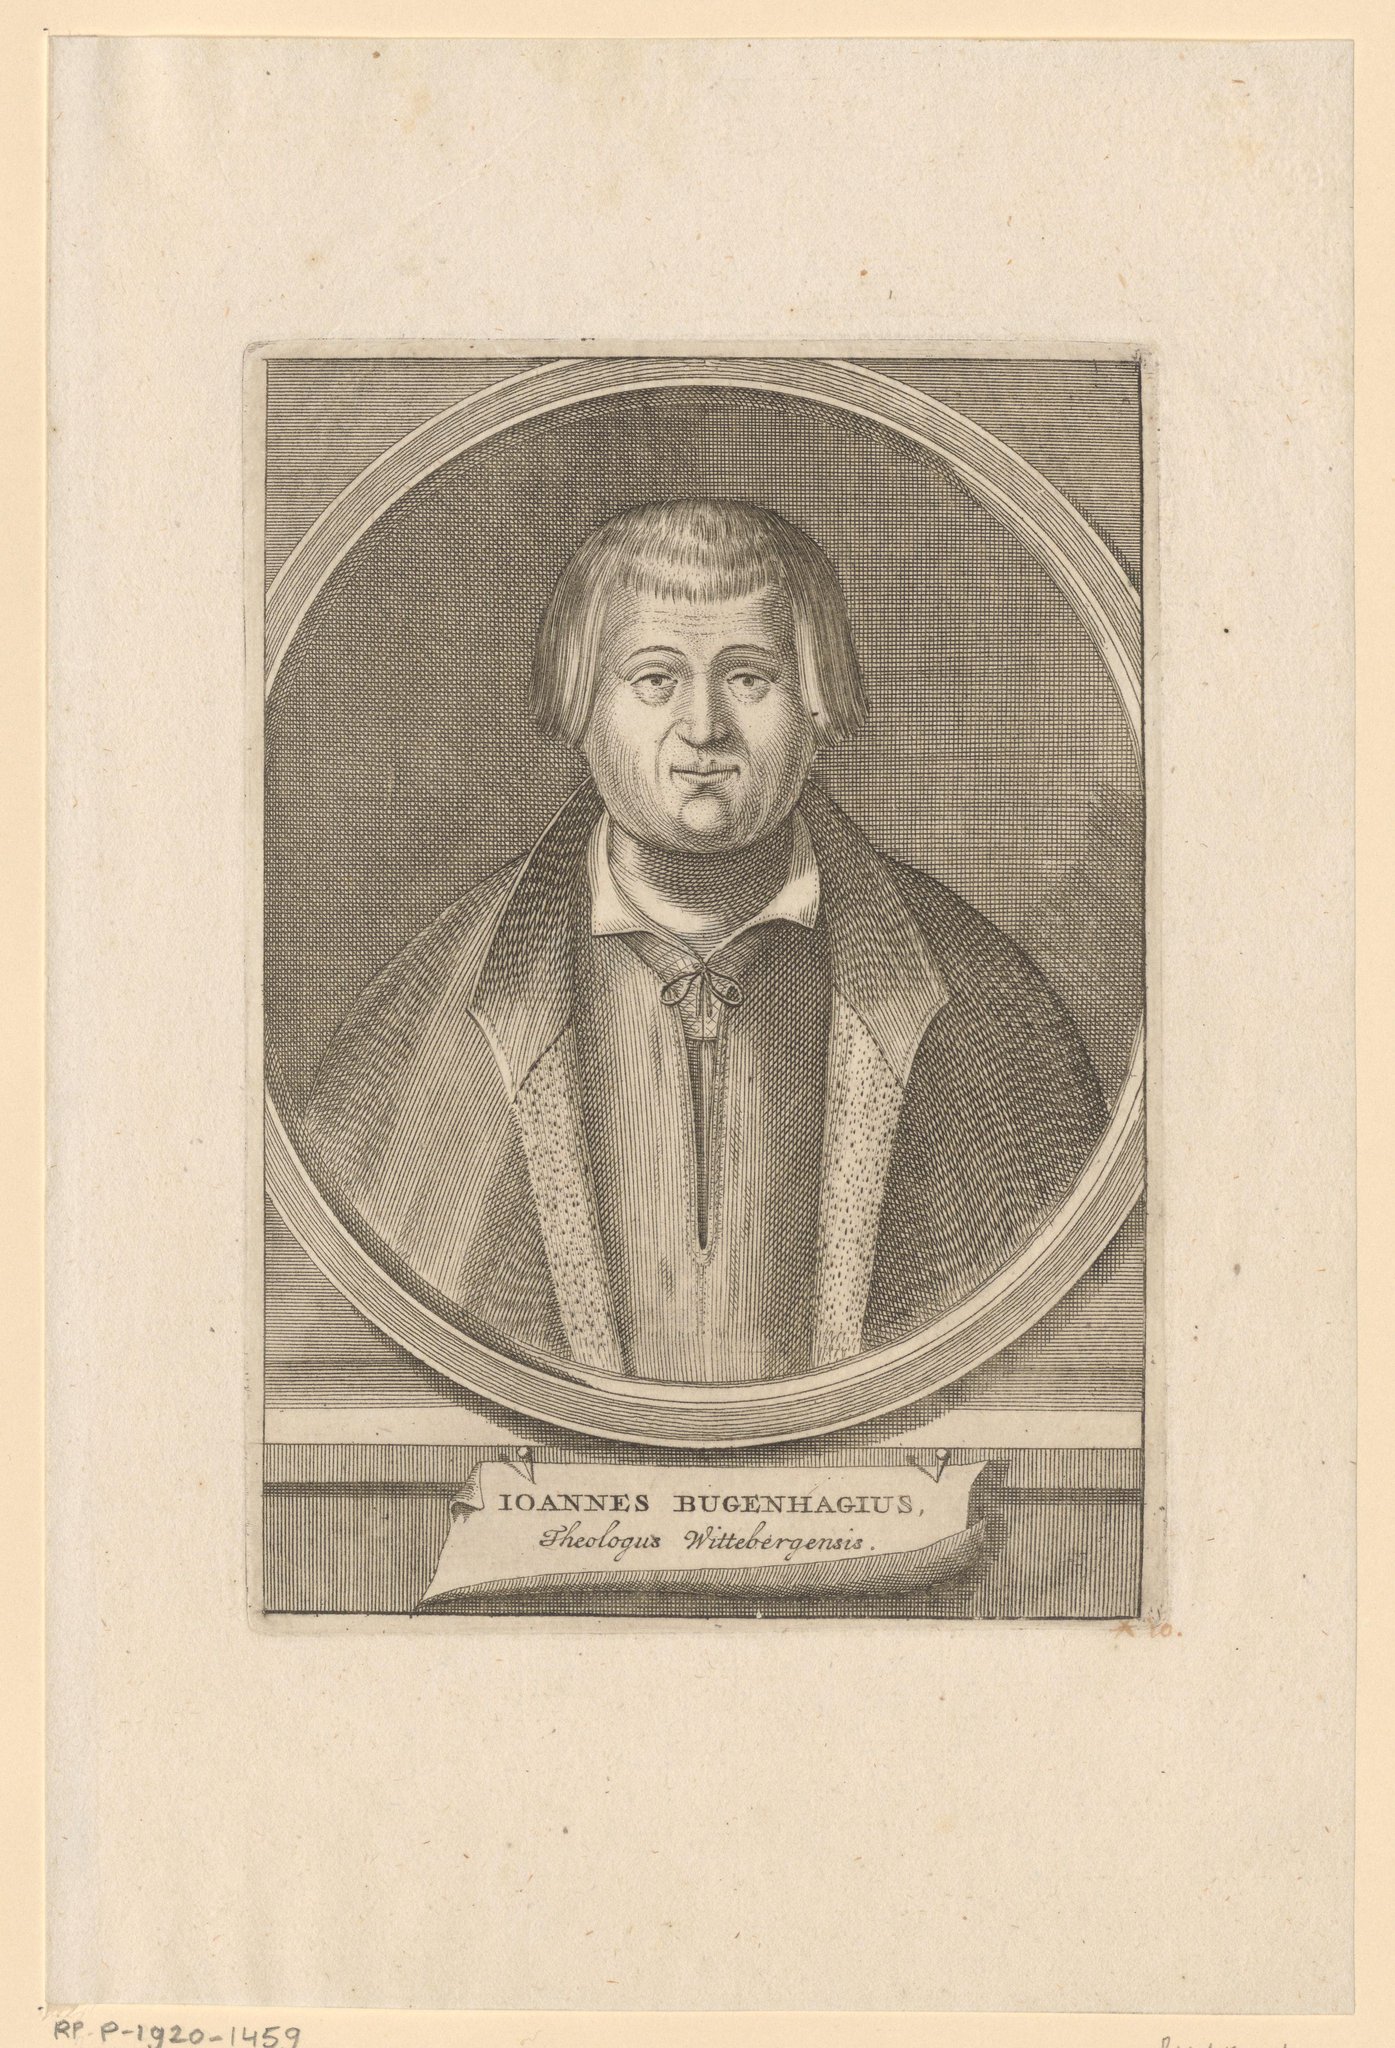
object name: print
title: Portret van Johannes Bugenhagen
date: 1599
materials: paper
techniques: engraving, etching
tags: theologian, historical persons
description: Eerdere staat van de prent gebruikt in: Icones virorum nostra patrumq. memoria illustrium (...). Den Haag: Hendrick Hondius (I), 1599. Prent ook gebruikt in verschillende latere publicaties.